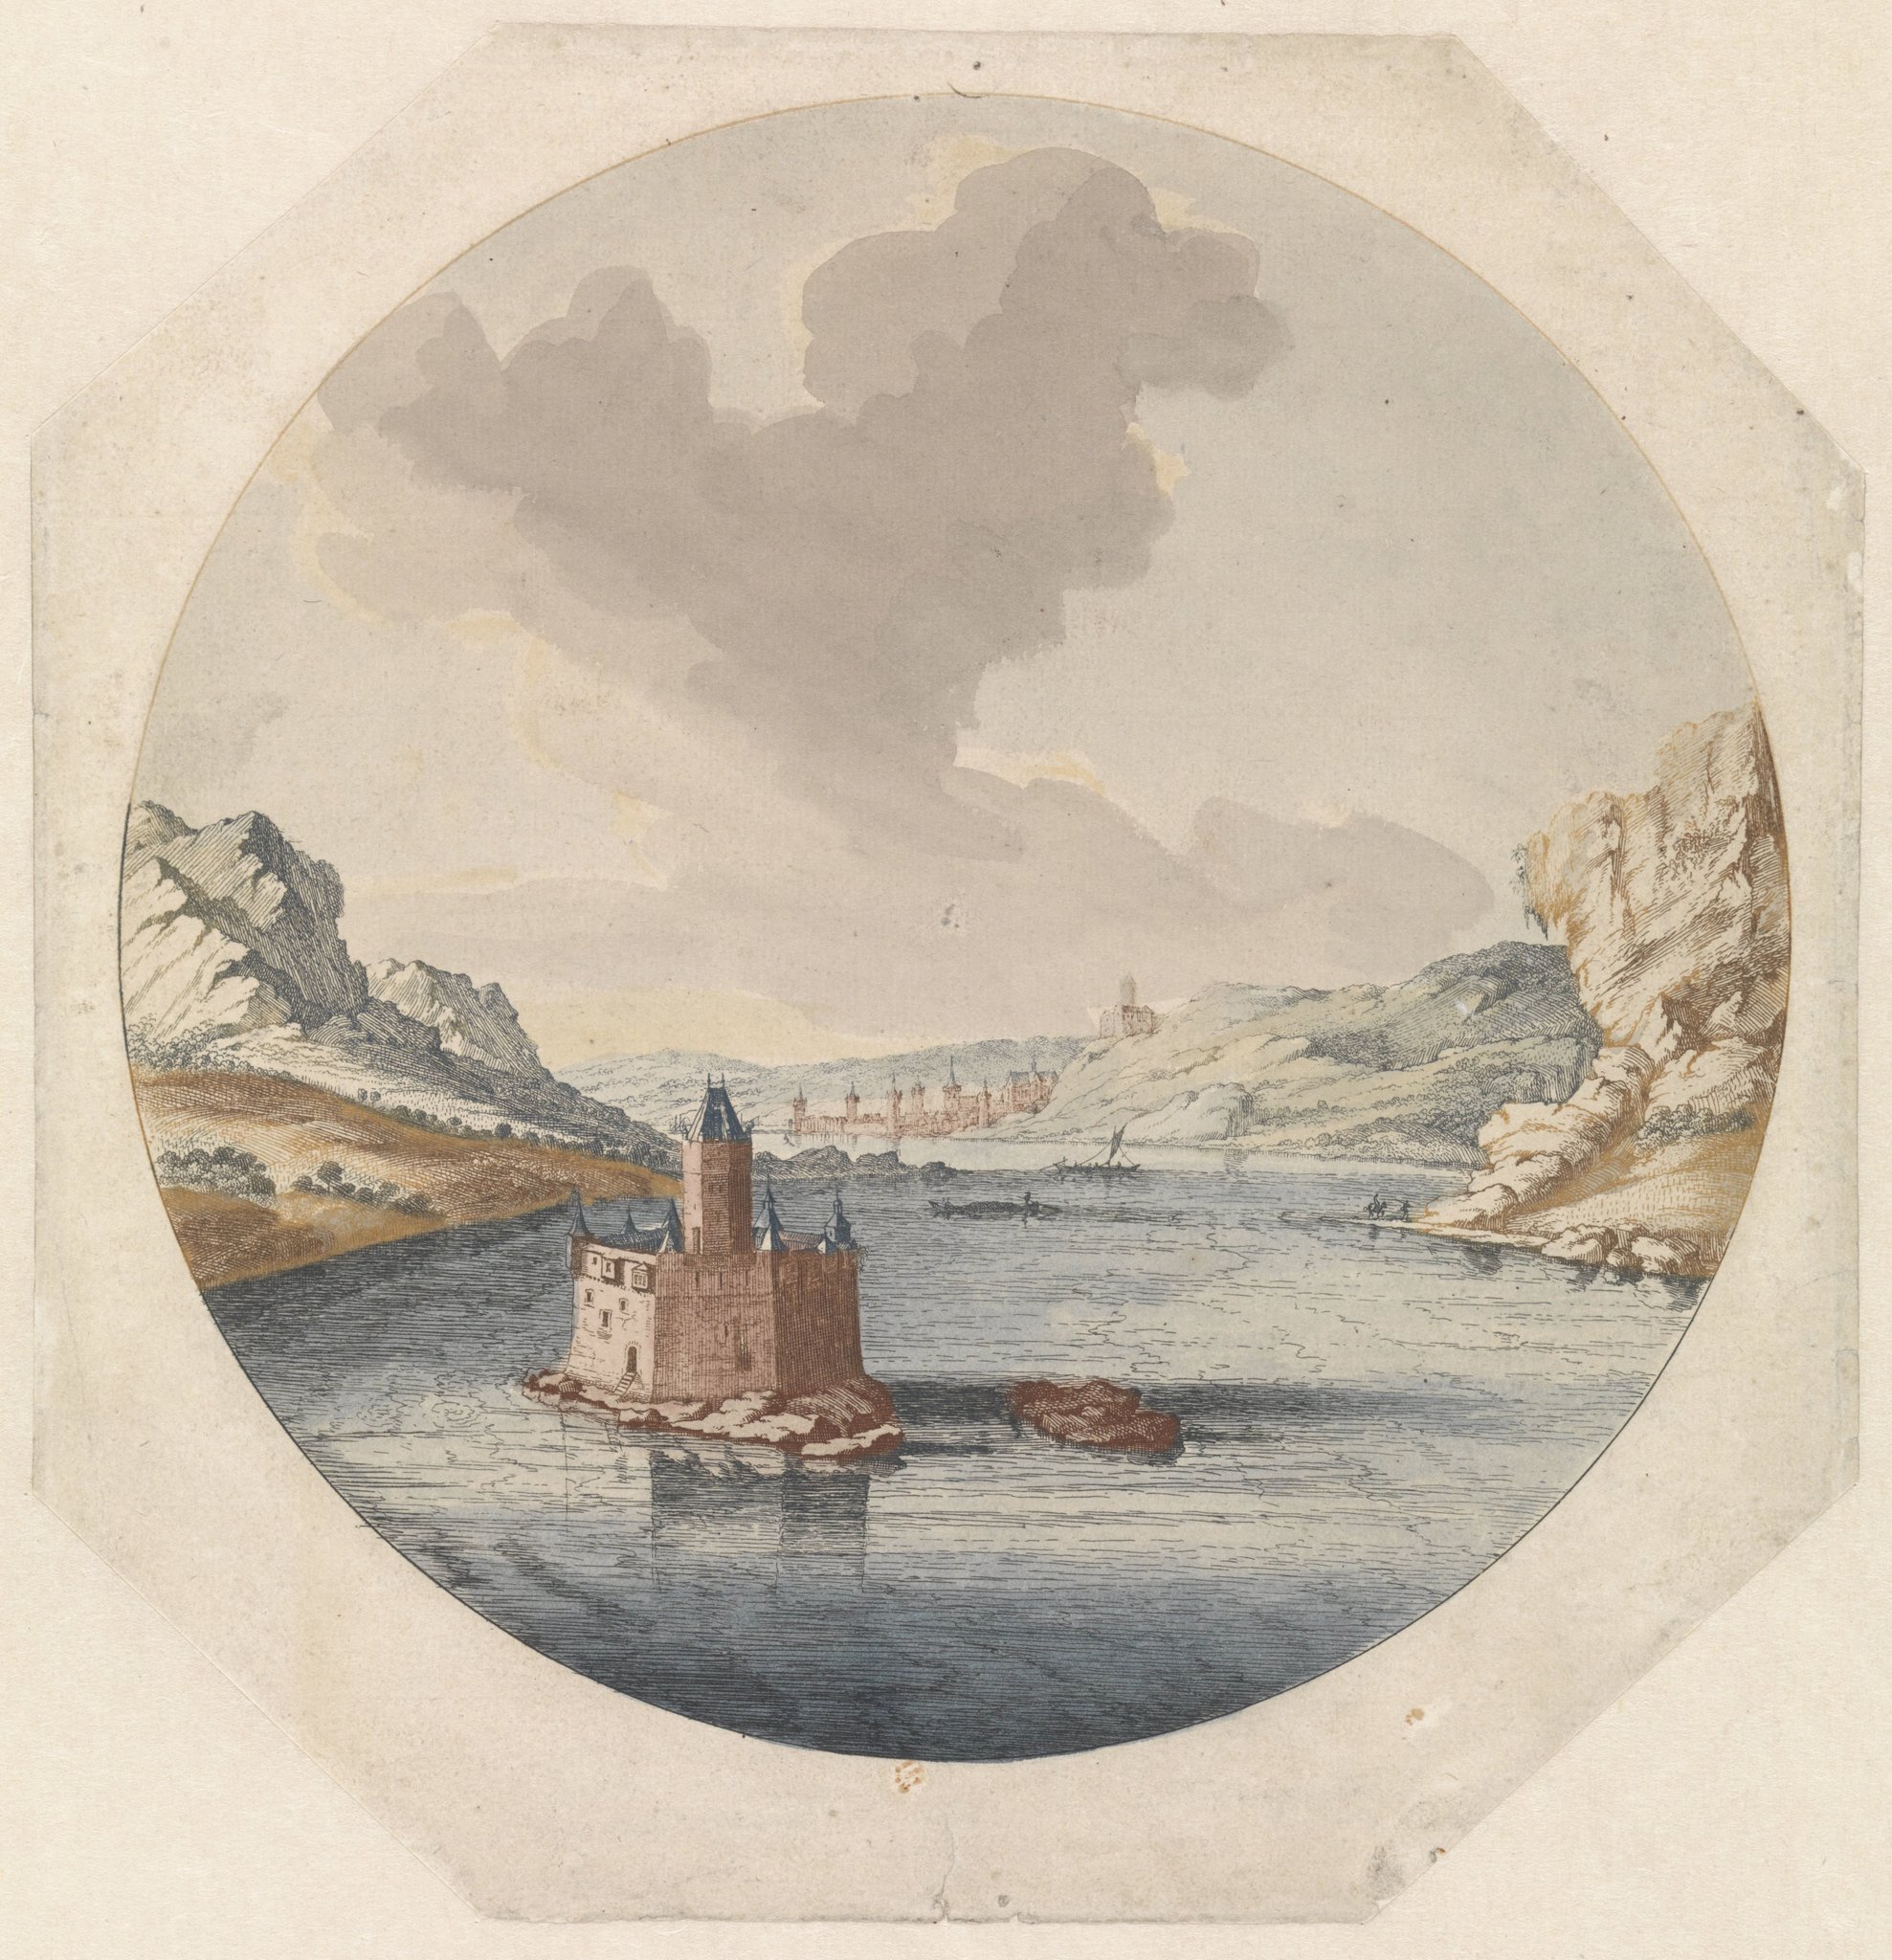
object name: print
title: Gezicht op burcht Pfalzgrafenstein bij Kaub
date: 1688-1698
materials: paper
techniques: etching, hand coloring, lithography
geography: netherlands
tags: fortress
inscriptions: collector's mark: Lugt 2228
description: Gezicht op de tolburcht Pfalzgrafenstein in de Rijn. Op de achtergrond de stad Kaub met daarboven op de heuvel burcht Gutenfels.